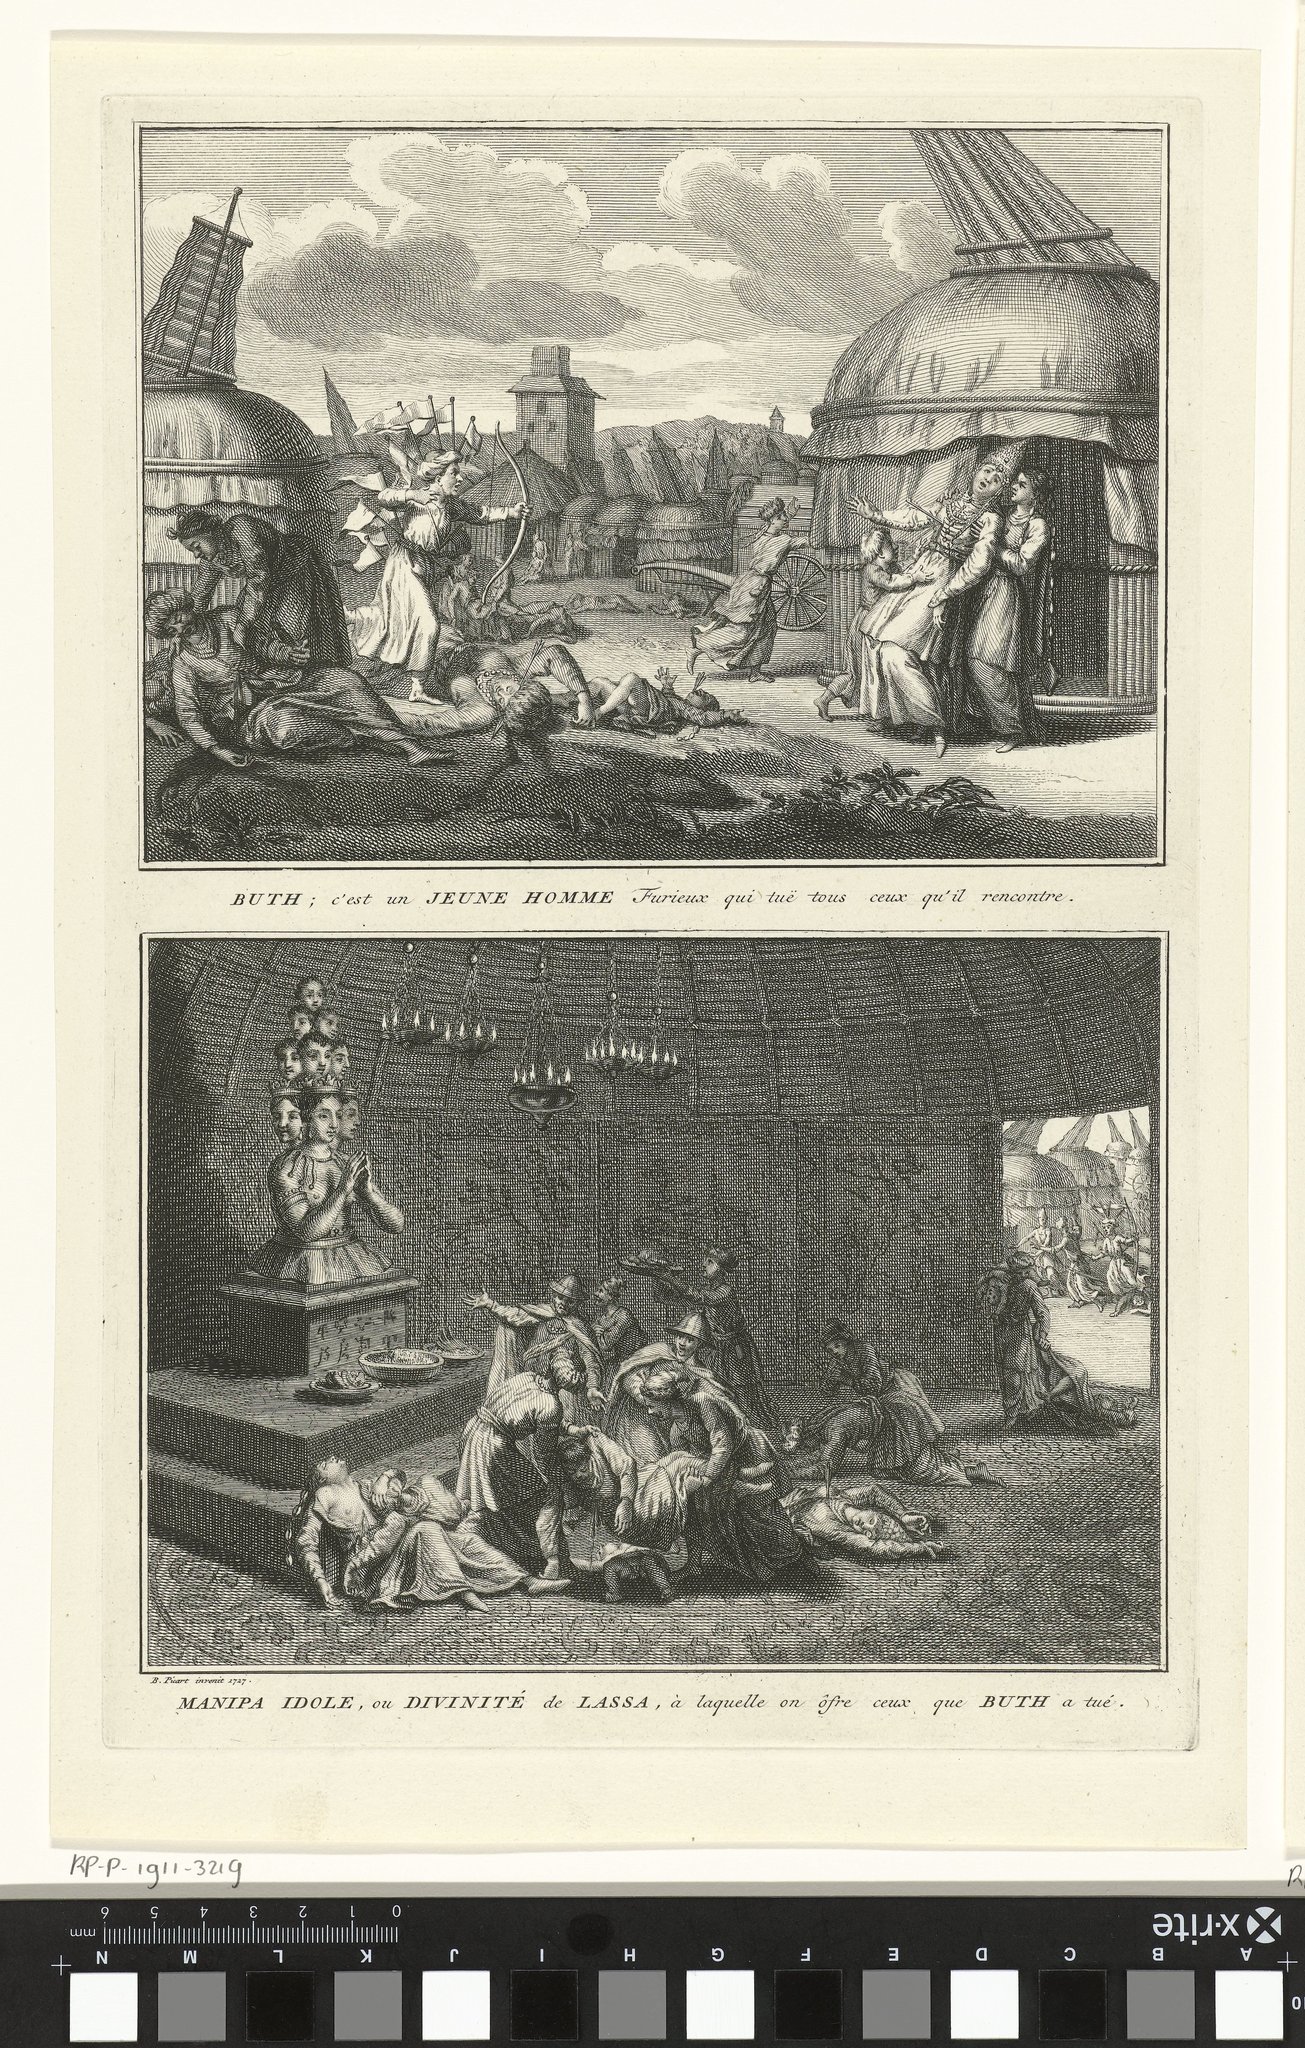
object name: book illustration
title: Daden van Buth, een Tataarse jongeman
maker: bernard picart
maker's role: draughtsman, print maker, publisher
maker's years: 1673-1733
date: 1727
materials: paper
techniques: engraving, etching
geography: amsterdam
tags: asiatic races and peoples, violent death by arrow(s)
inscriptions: collector's mark: Lugt 2228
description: Prent ook gebruikt in: Picart, Bernard. Naaukeurige beschryving der uitwendige godtsdienst-plichten, kerk-zeden en gewoontens van alle volkeren der waereldt, deel IV. [Vertaald in het Nederlands door] Moubach, Abraham. Den Haag, Amsterdam, Rotterdam: Rutgert Alberts, Hermannus Uytwerf, Jan Daniel Beman, Isaac van der Kloot, 1727-1738. Prent ook gebruikt in: Cérémonies et coutumes religieuses de tous les peuples du monde: représentées par des figures (...), deel II (deel I), na p. 354. Amsterdam: Jean Frédéric Bernard, 1728.